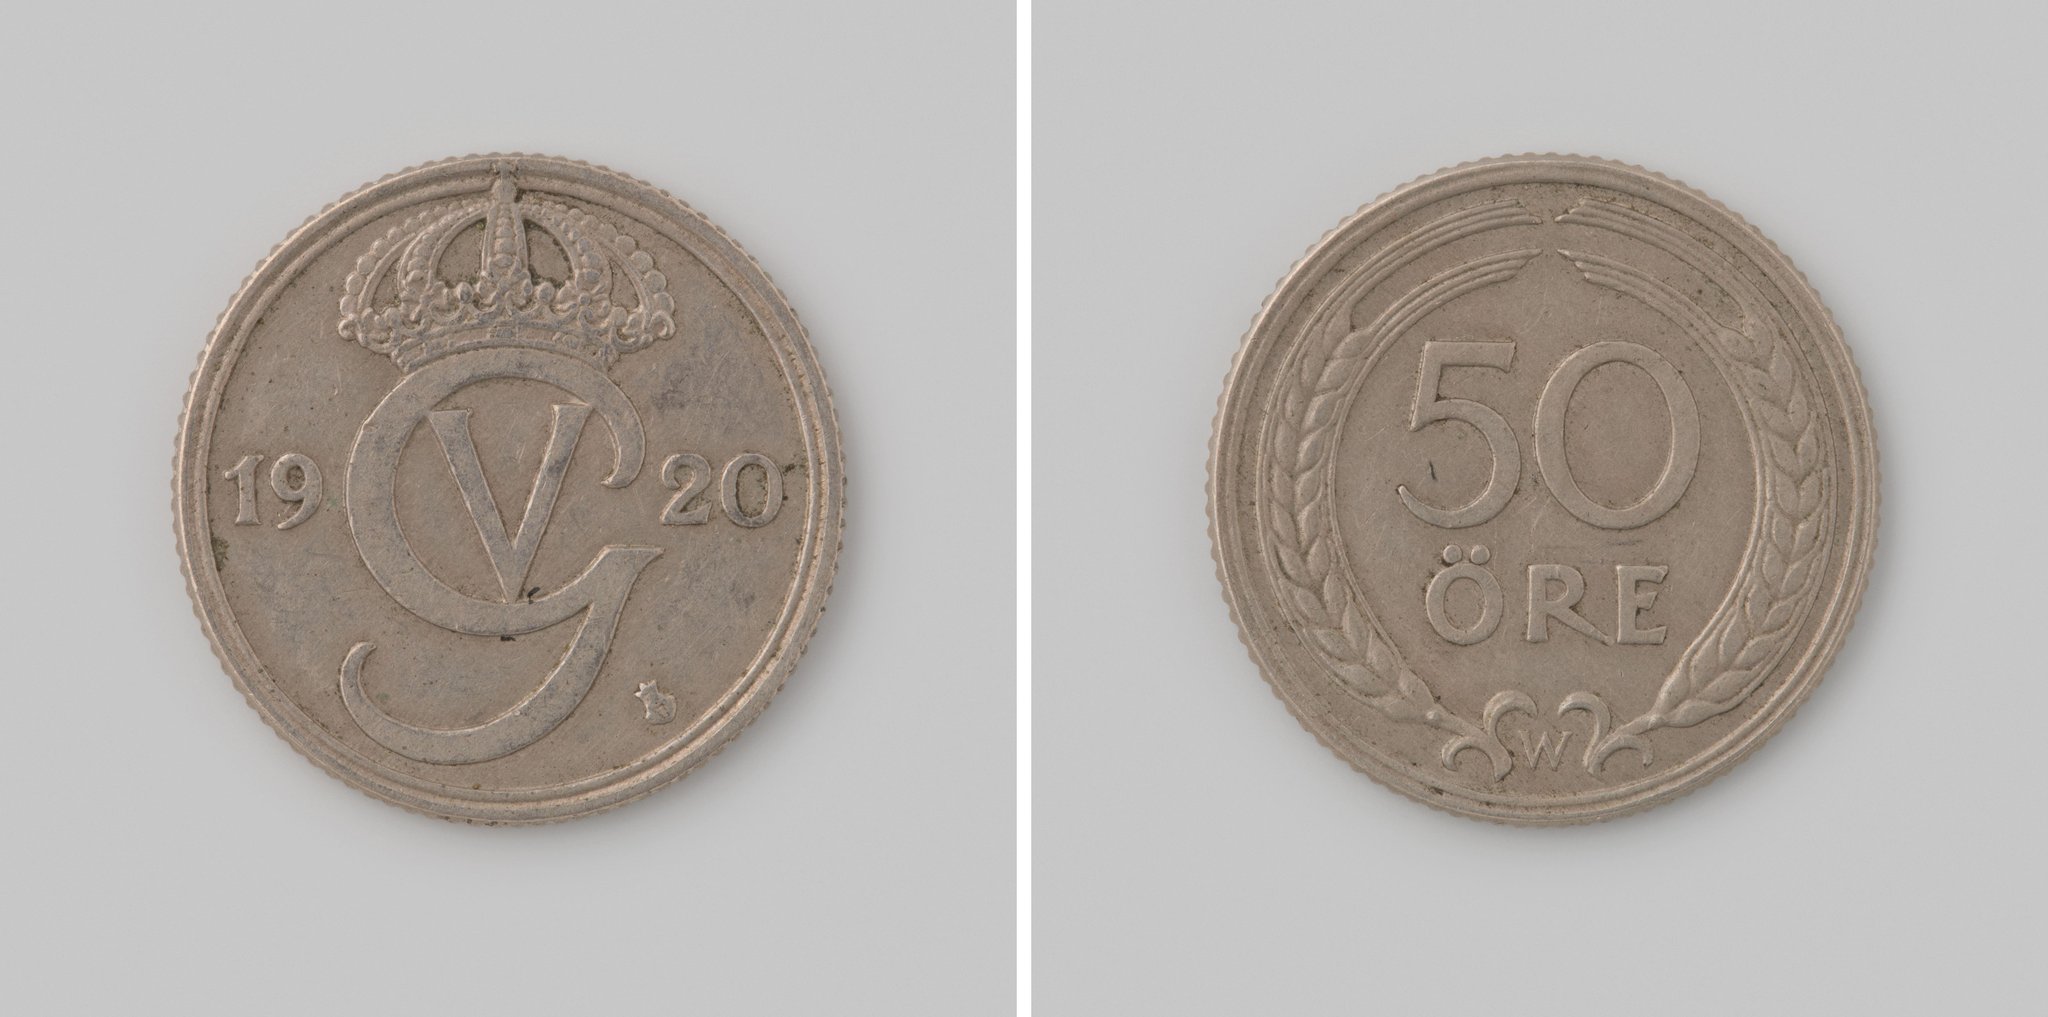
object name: coin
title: 50 öre uit Zweden van Gustav V, 1920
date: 1920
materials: nickel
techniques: striking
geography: slot rörstrand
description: Nikkelen munt. Voorzijde: tussen drie kronen monogram van de koning, waarboven koningskroon. Keerzijde: binnen twee samengebonden takken waarde-aanduiding in twee regels. Daaronder jaartal. Gladde rand.